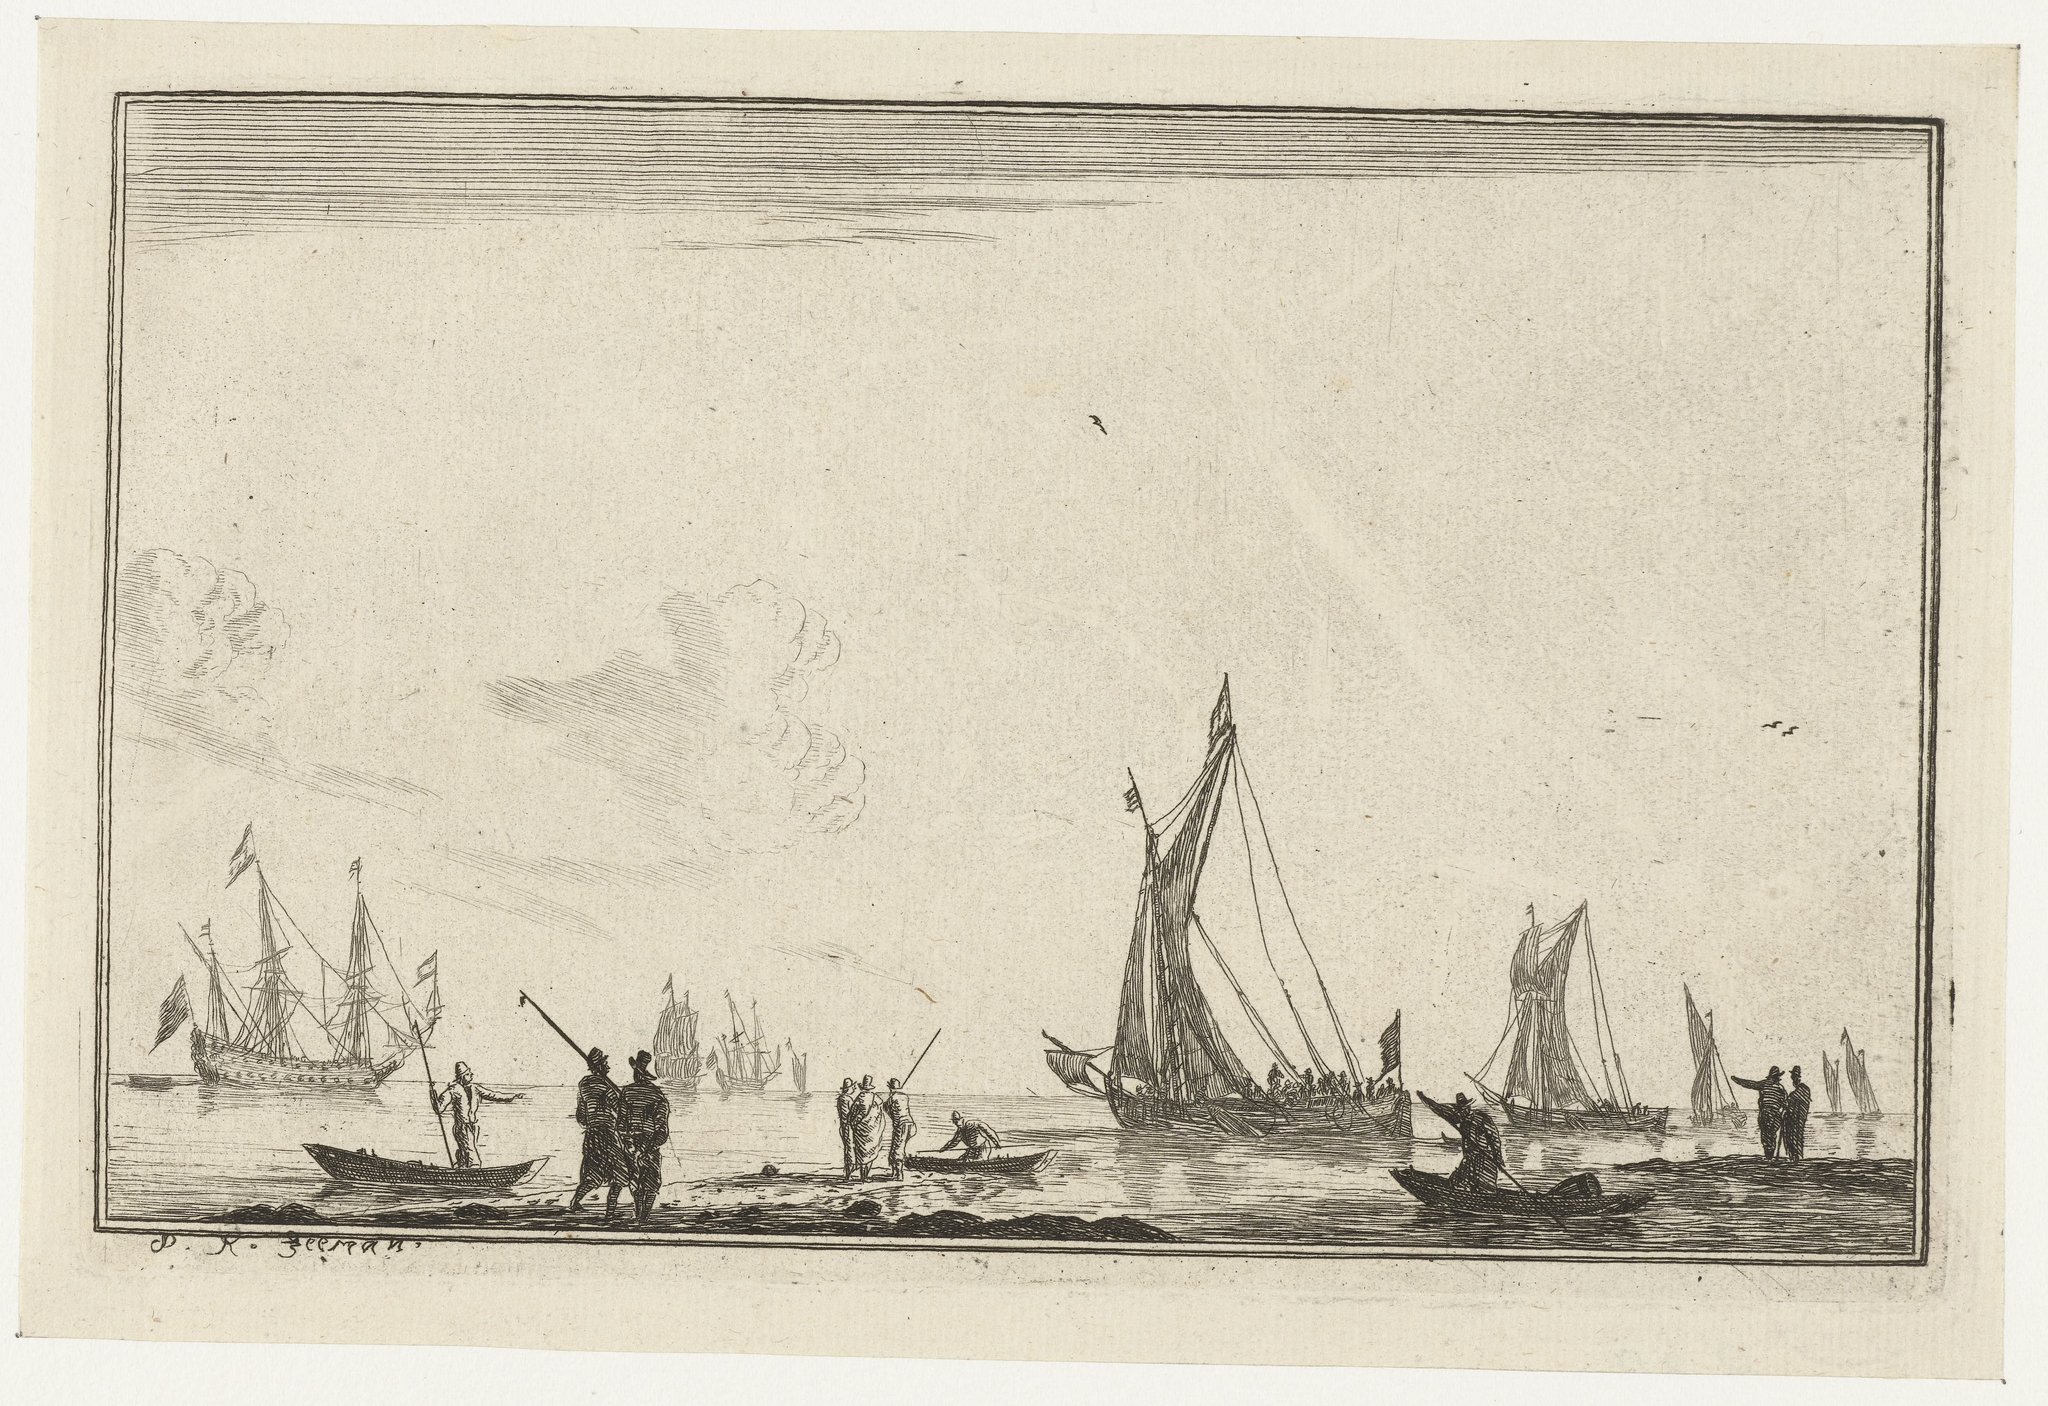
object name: print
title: Binnenwateren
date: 1654-1748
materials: paper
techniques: etching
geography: netherlands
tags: sailing-ship, sailing-boat, water course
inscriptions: collector's mark: Lugt 12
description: Groot binnenwater met een aantal zeilschepen, links een koopvaardijschip. Op de voorgrond een aantal mensen staand op de oever en drie kleine bootjes. Dubbele rand rondom voorstelling .